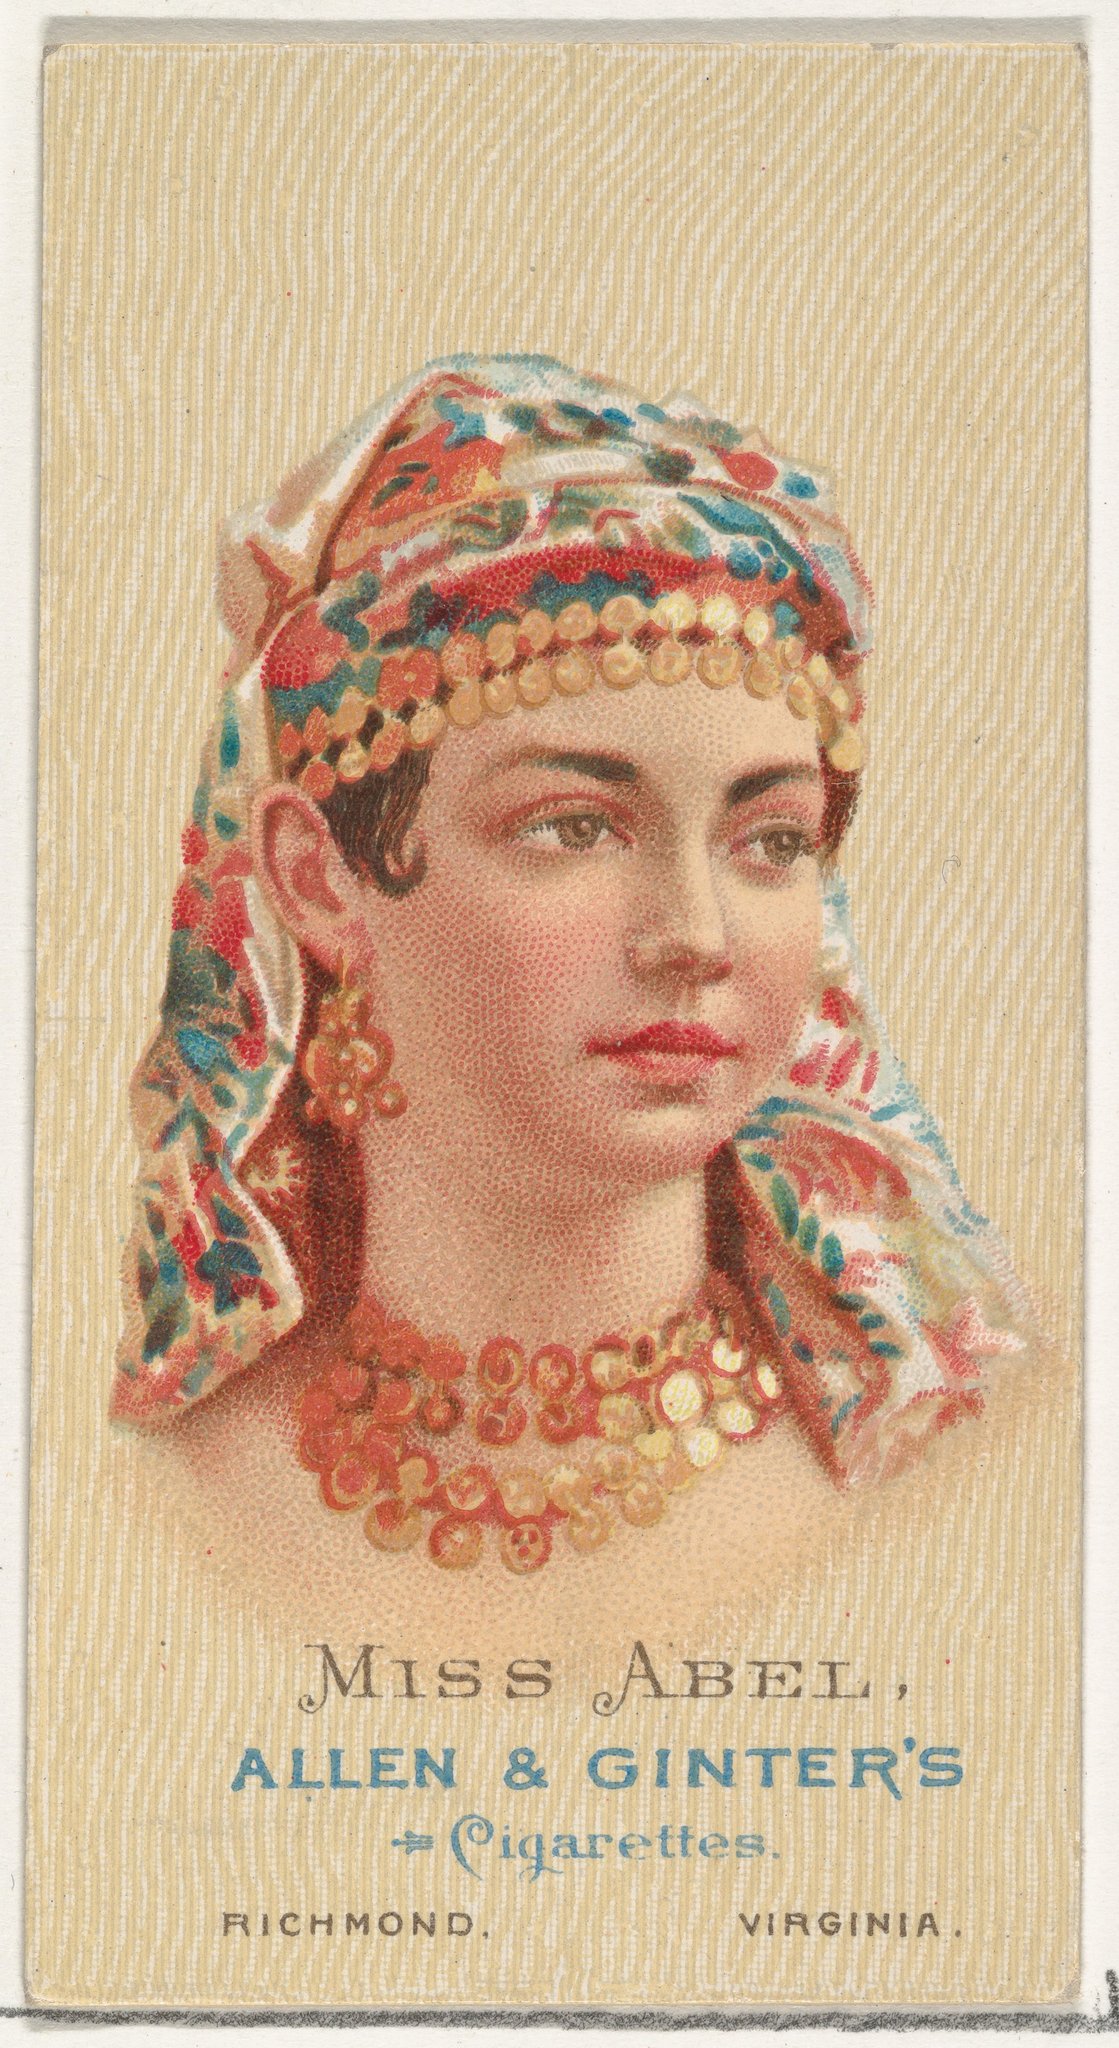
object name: print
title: Miss Abel, from World's Beauties, Series 2 (N27) for Allen & Ginter Cigarettes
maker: allen & ginter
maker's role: publisher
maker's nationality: american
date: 1888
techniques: color lithograph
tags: women